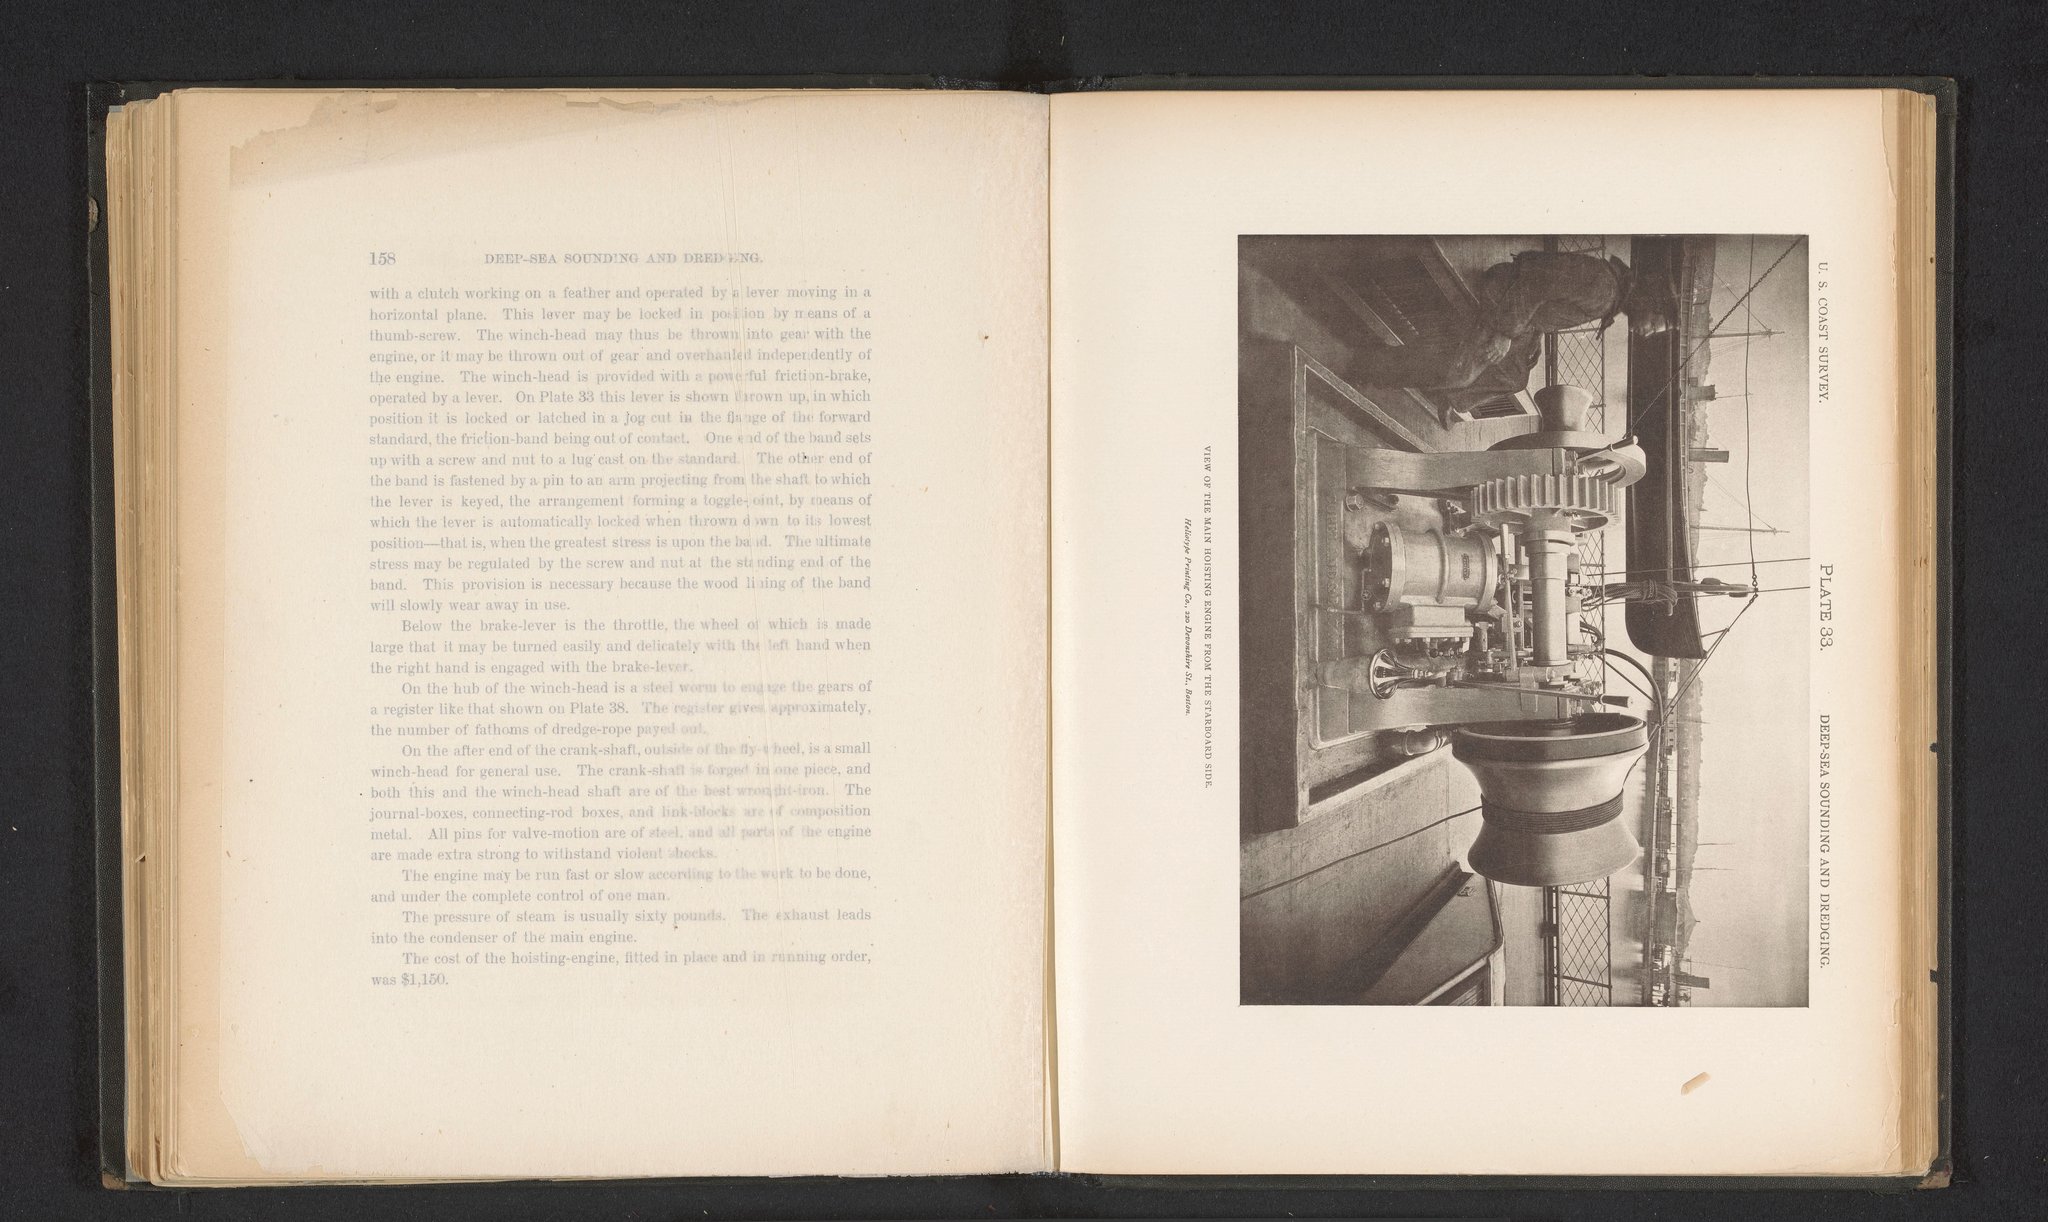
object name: page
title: Hijsmotor op het dek van de George S. Blake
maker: Anonymous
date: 1870-1880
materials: paper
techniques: photograph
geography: united states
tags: drawing, pulling something, ships (in general), machines, engines ~ crafts and industries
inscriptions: name: ‘Heliotype Printing Co., 220 Devonshire St., Boston.’, number: ‘Plate 33.’, inscription: ‘View of the main hoisting engine from the starboard side.’